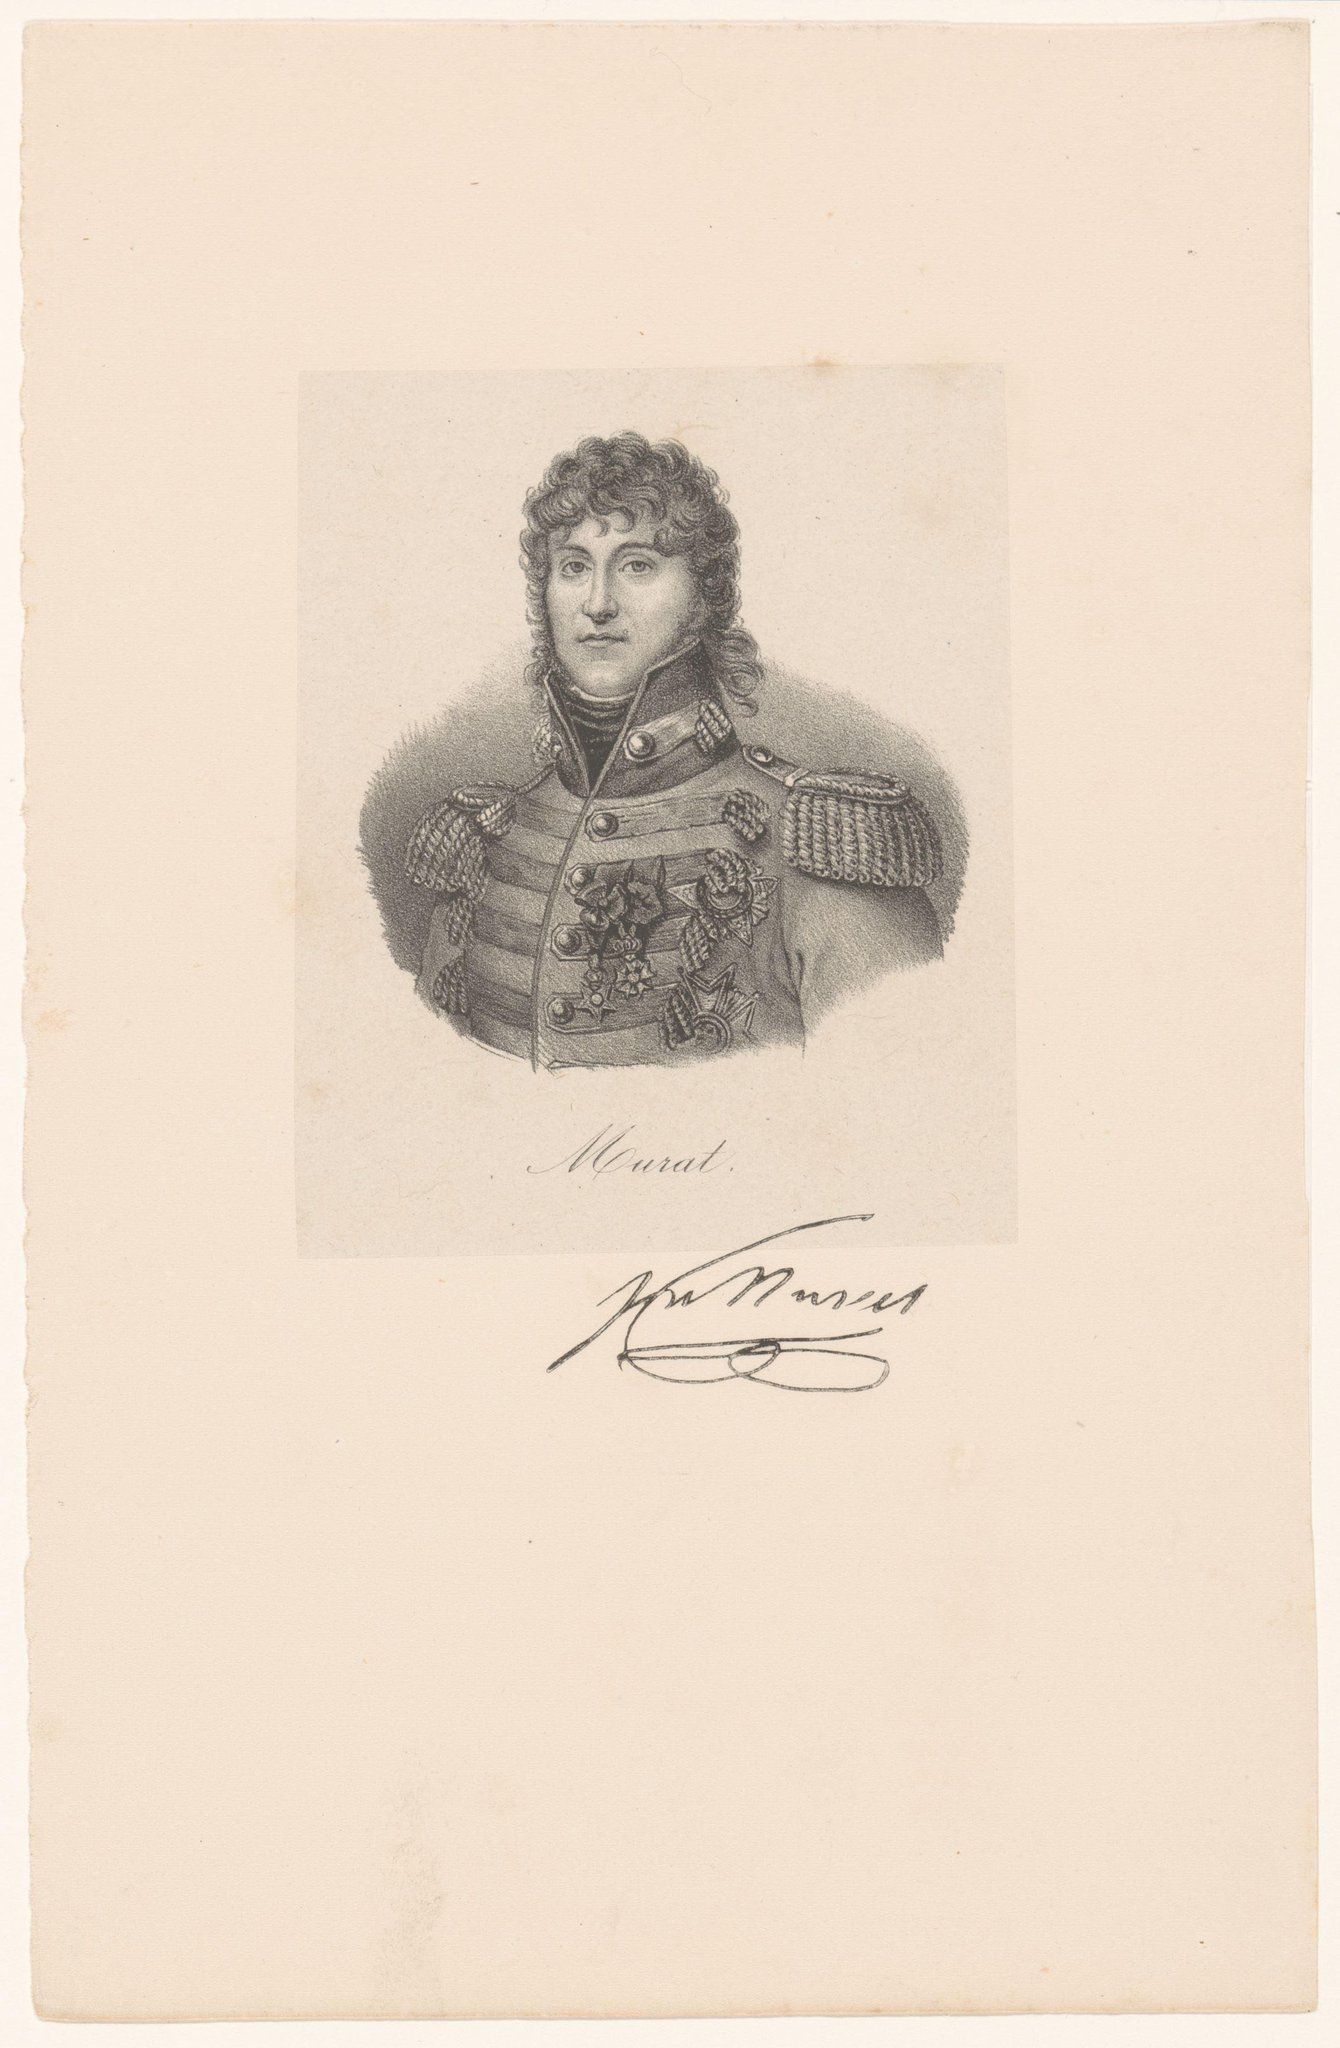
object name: print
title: Murat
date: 1818-1842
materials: paper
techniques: lithograph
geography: paris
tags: pizzo, historical persons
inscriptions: collector's mark: Lugt 2228a